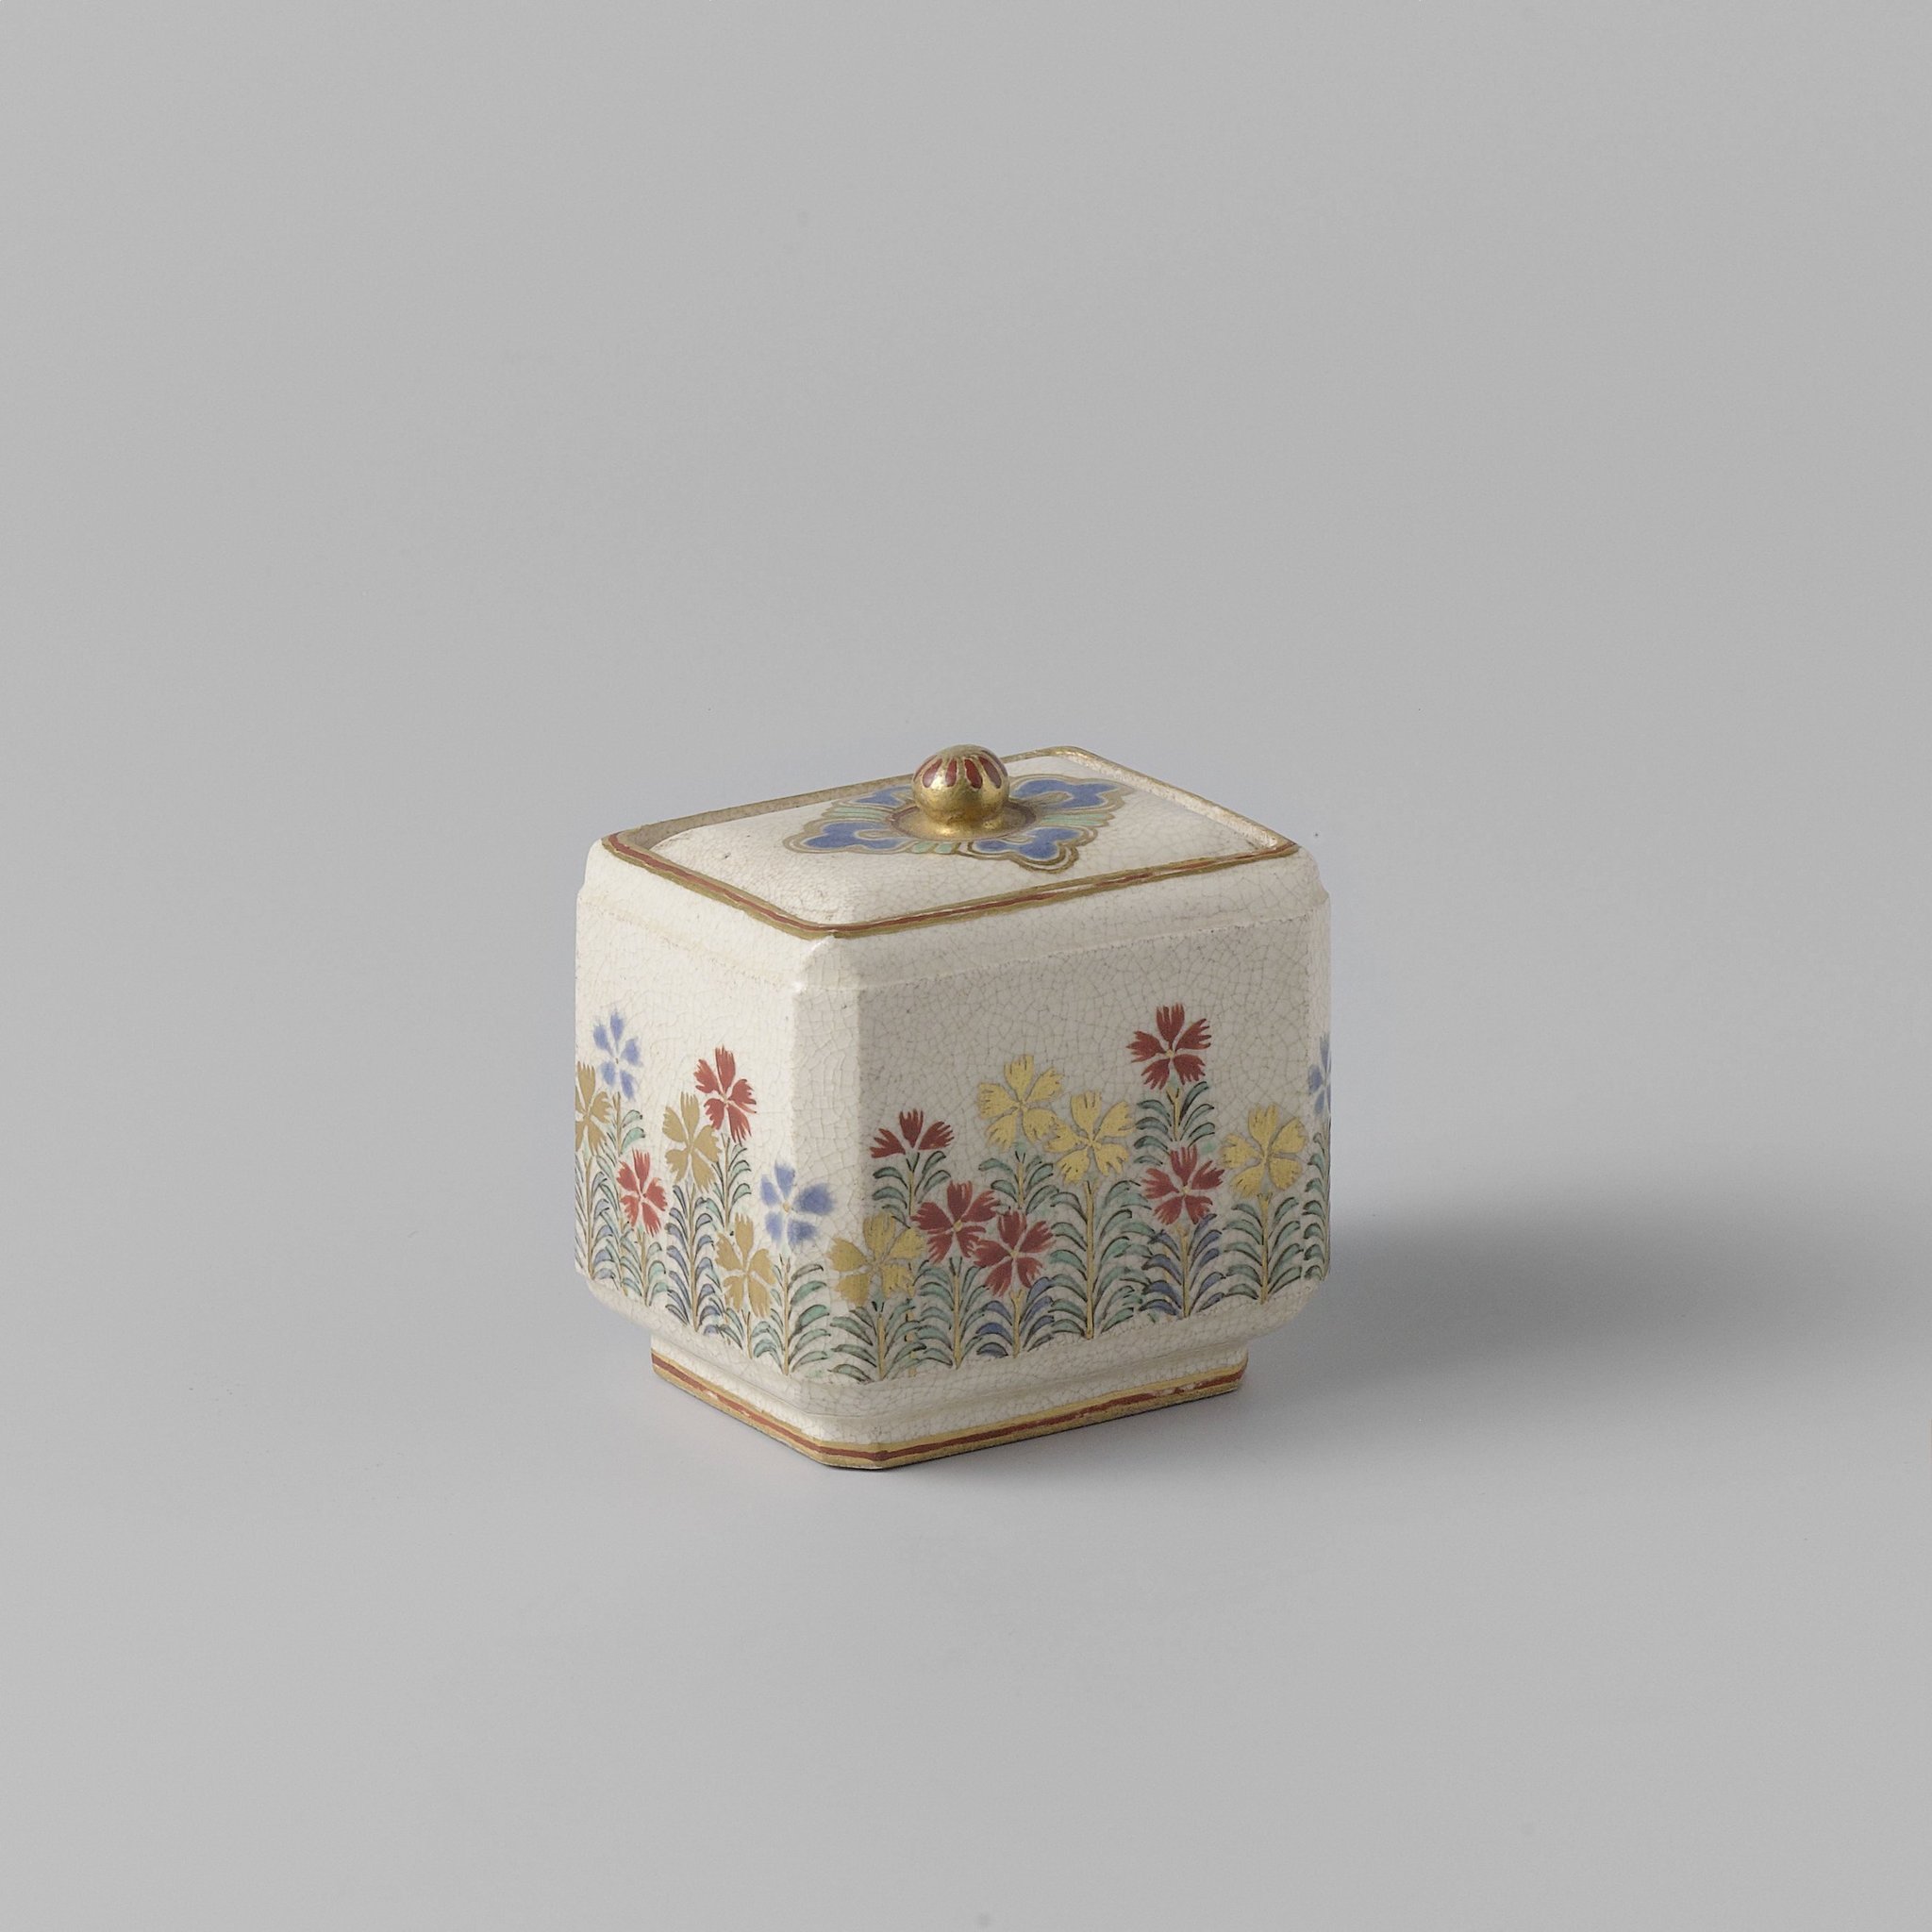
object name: box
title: Incense box with flowering plants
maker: Anonymous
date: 1860-1880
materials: glaze, gold, paint, stoneware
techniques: firing, forming, gilding, vitrification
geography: satsuma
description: Rechthoekige wierookdoos van steengoed, beschilderd op het glazuur in blauw, rood, groen, zwart en goud. Op de wanden een doorlopende band met prachtanjers (nadeshiko). Rond de rechthoekige dekselknop een gelobde ruit; de dekselknop met een gestileerde bloem. Satsuma.